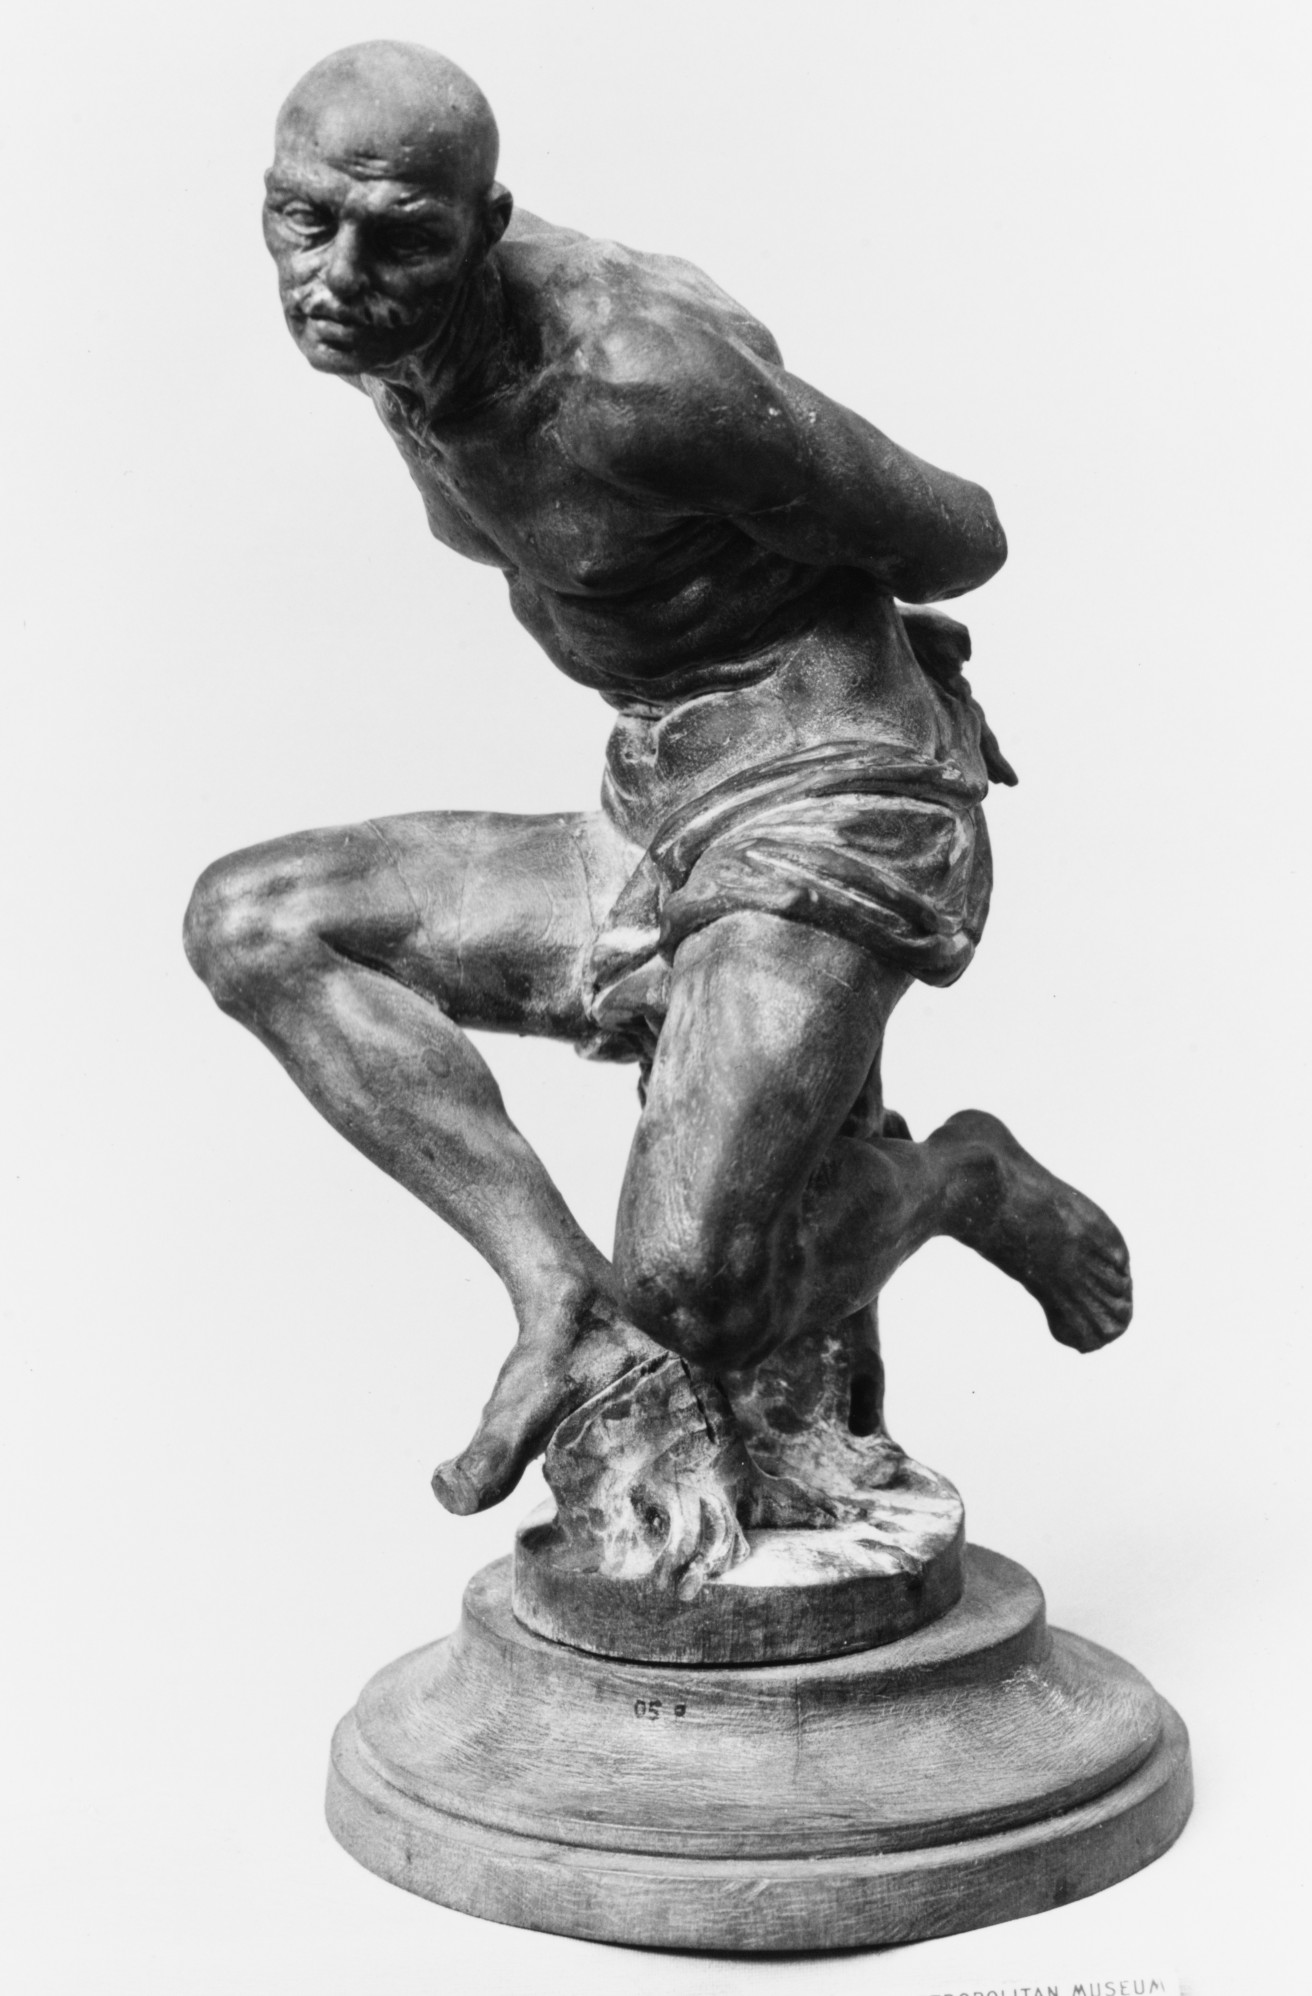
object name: statuette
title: The Captured Turk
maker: pietro tacca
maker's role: artist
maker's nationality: italian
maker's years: 1577-1640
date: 1601-1700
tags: men